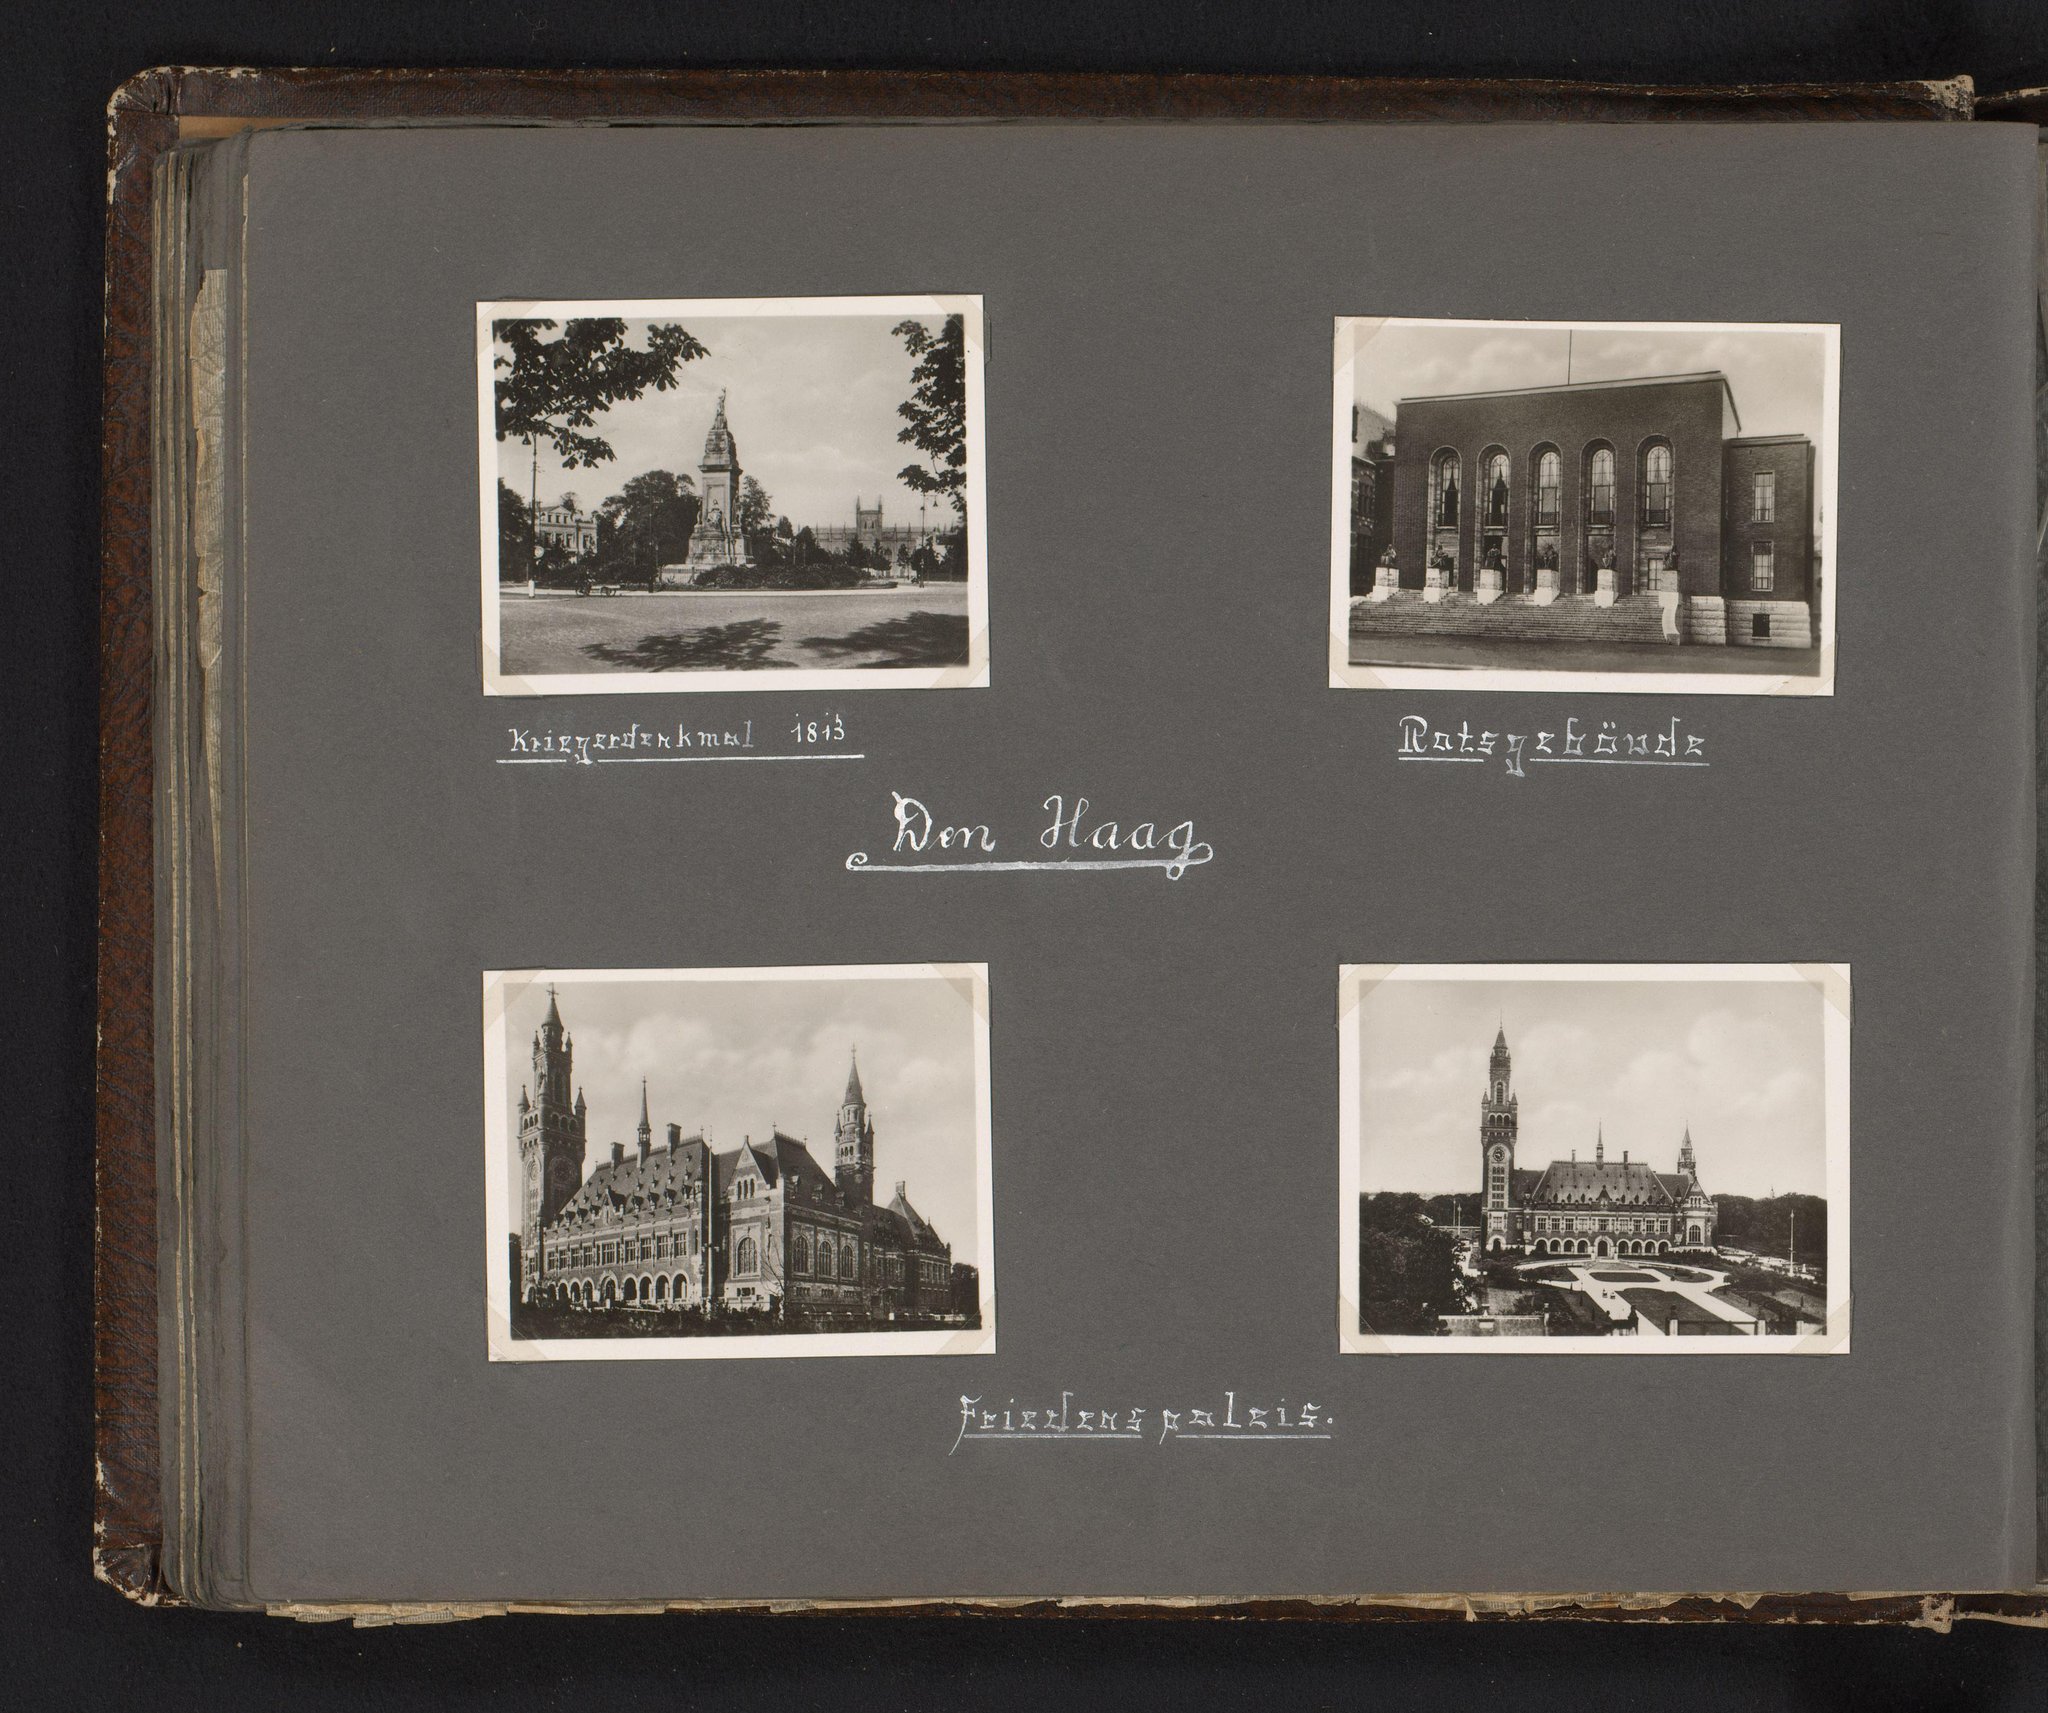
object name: photograph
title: Den Haag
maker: Anonymous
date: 1935-1942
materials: paper, photographic support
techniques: gelatin silver print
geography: the hague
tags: city-view in general; 'veduta', the hague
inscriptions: inscription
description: Albumblad met vier (gekochte) foto's van bezienswaardigheden in Den Haag. Onderdeel van het fotoalbum Kriegsmarine.